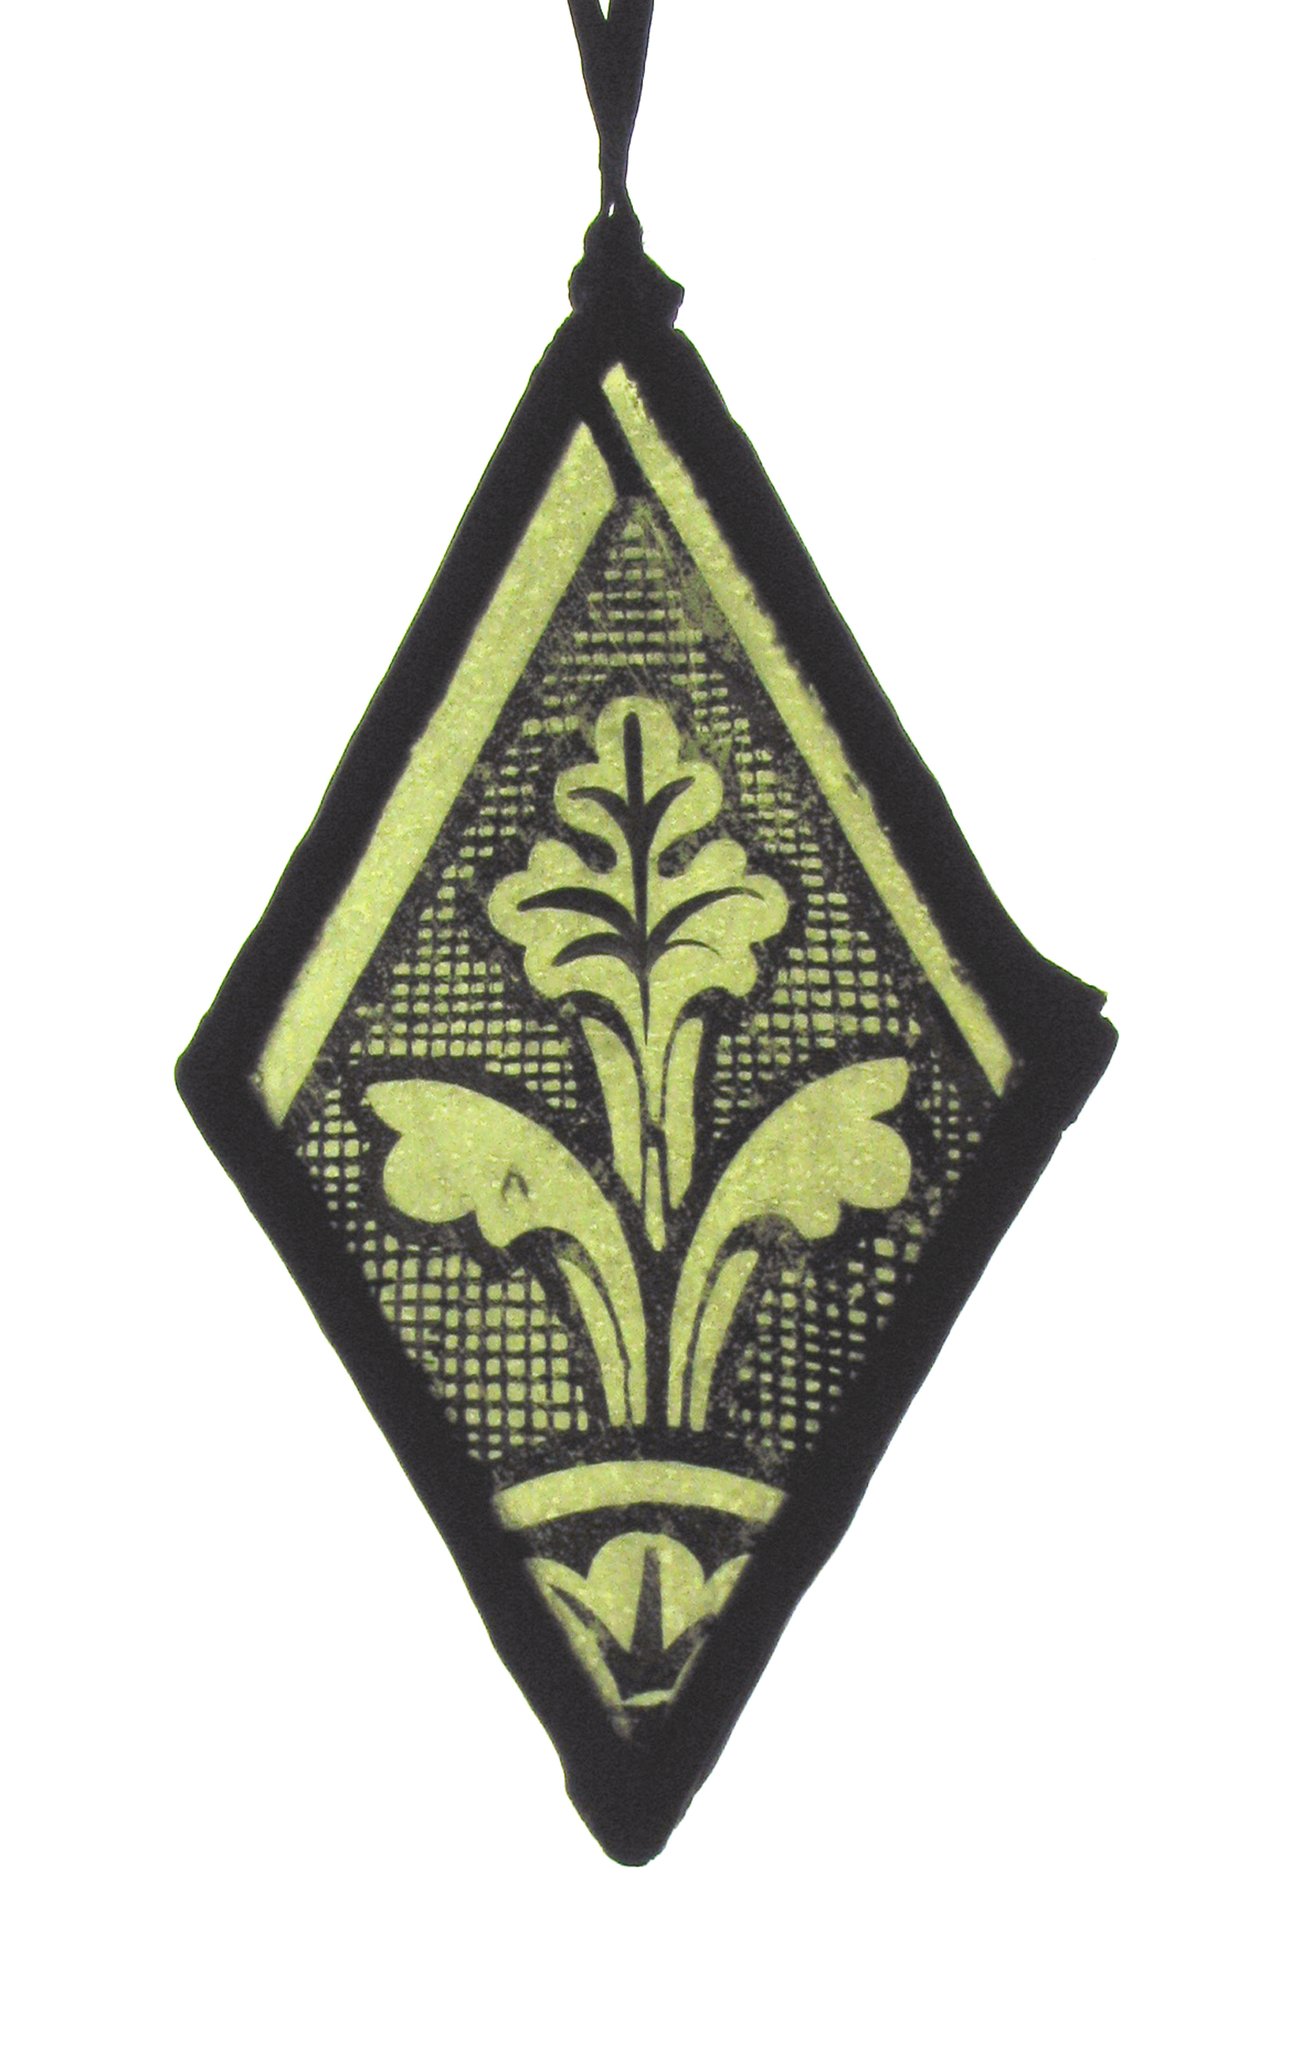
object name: fragment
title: Glass Fragment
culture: french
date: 1201-1300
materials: glass